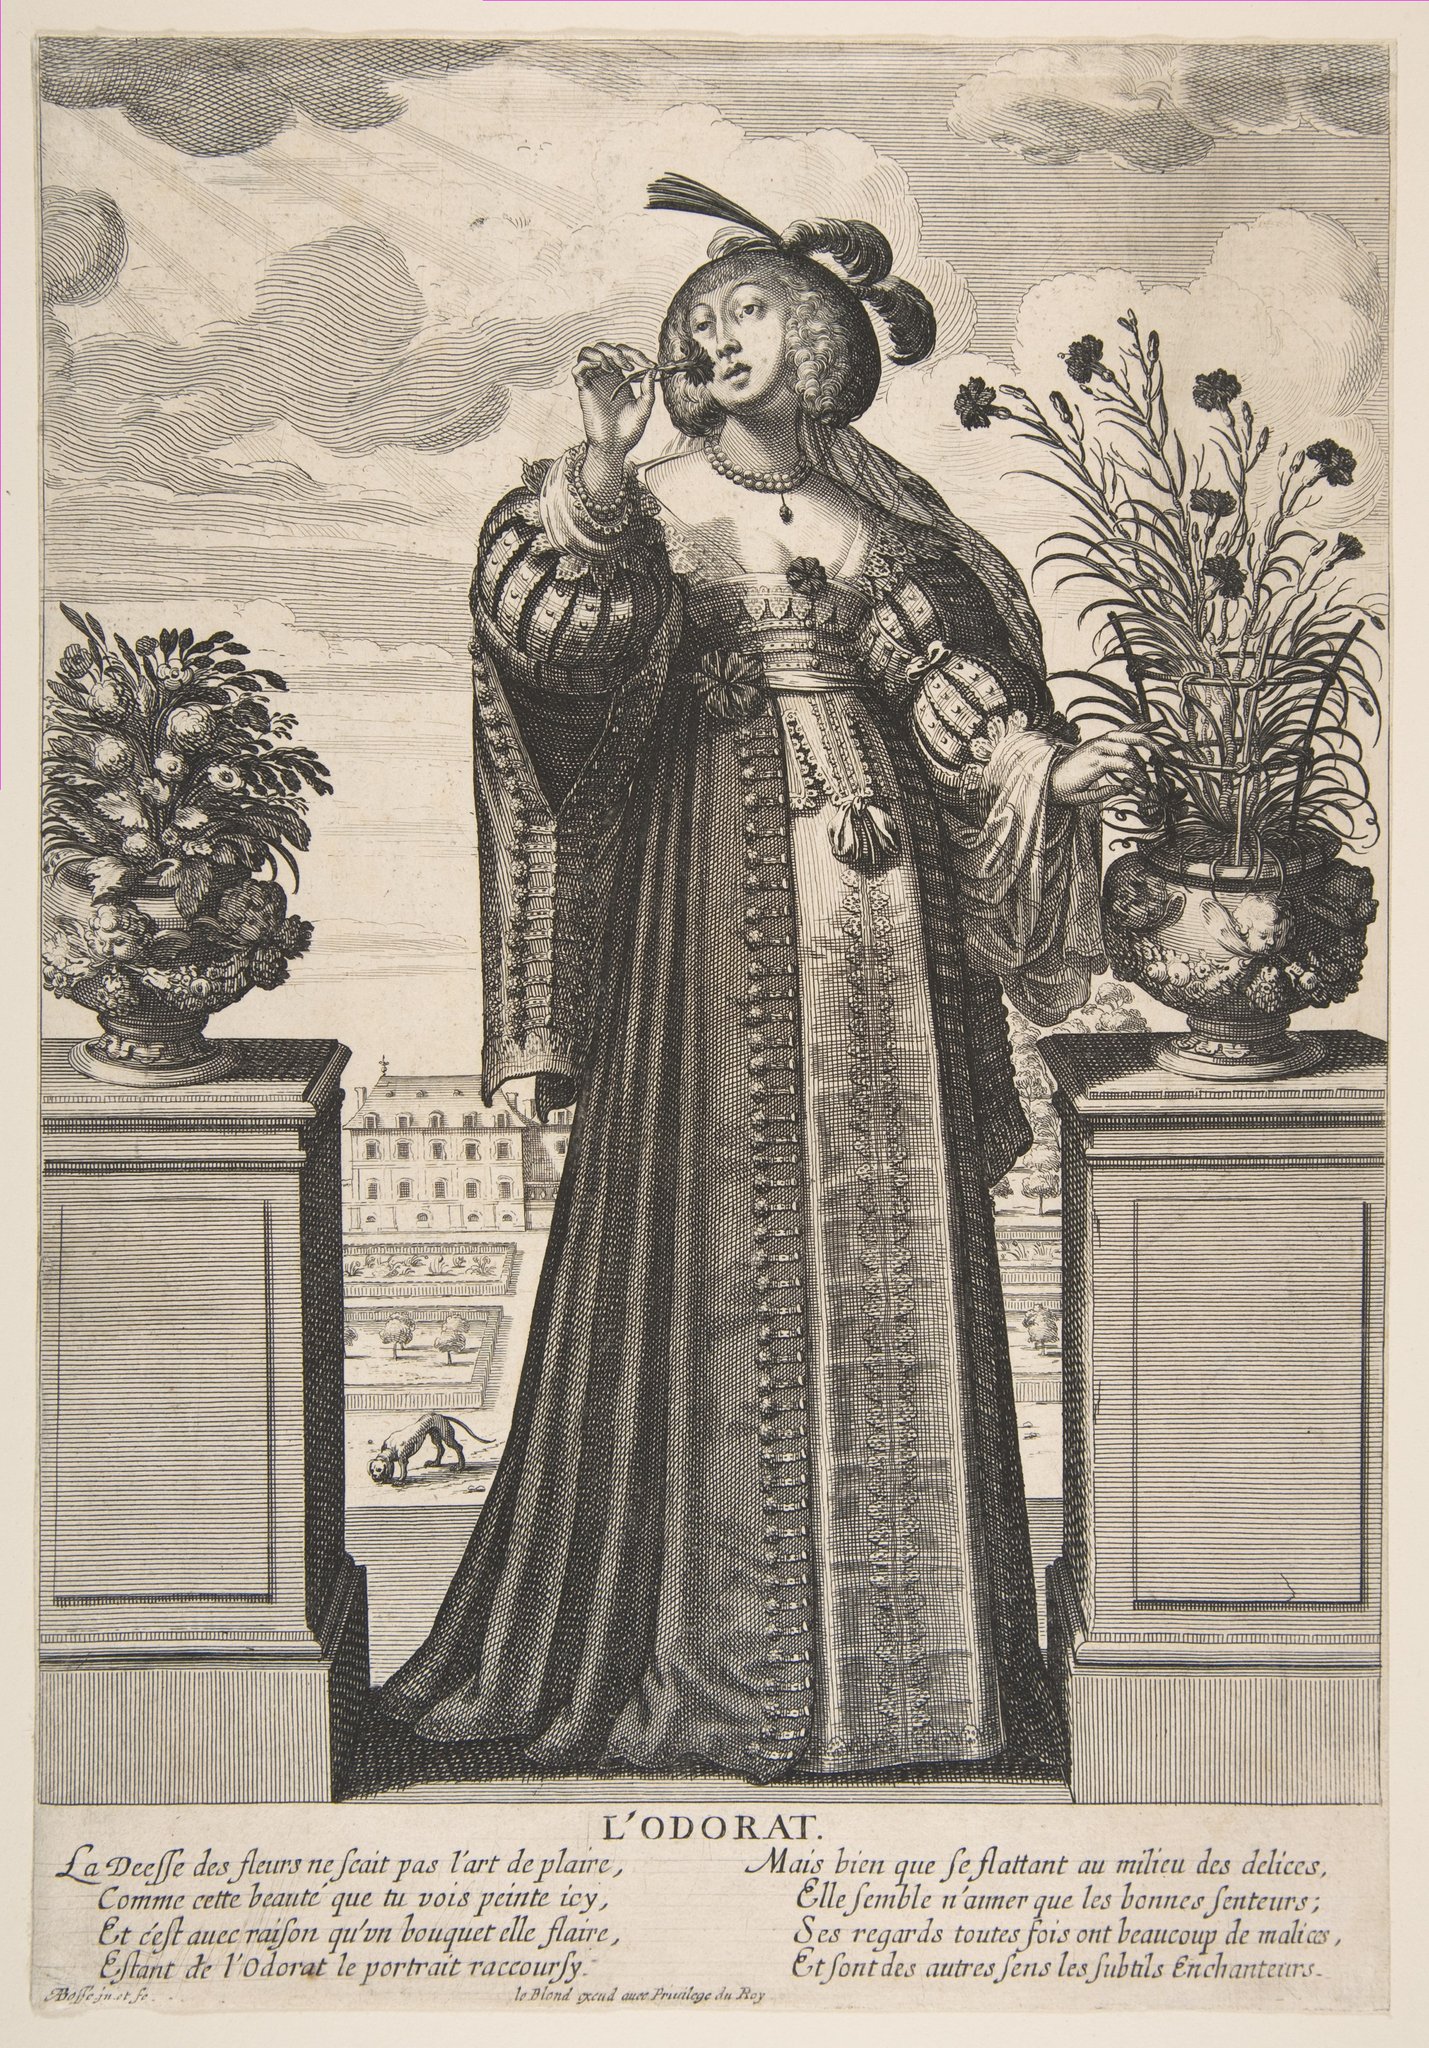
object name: print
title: Smell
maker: abraham bosse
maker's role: artist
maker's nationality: french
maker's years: 1602-1676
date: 1635-1638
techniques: etching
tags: women,flowers,plants